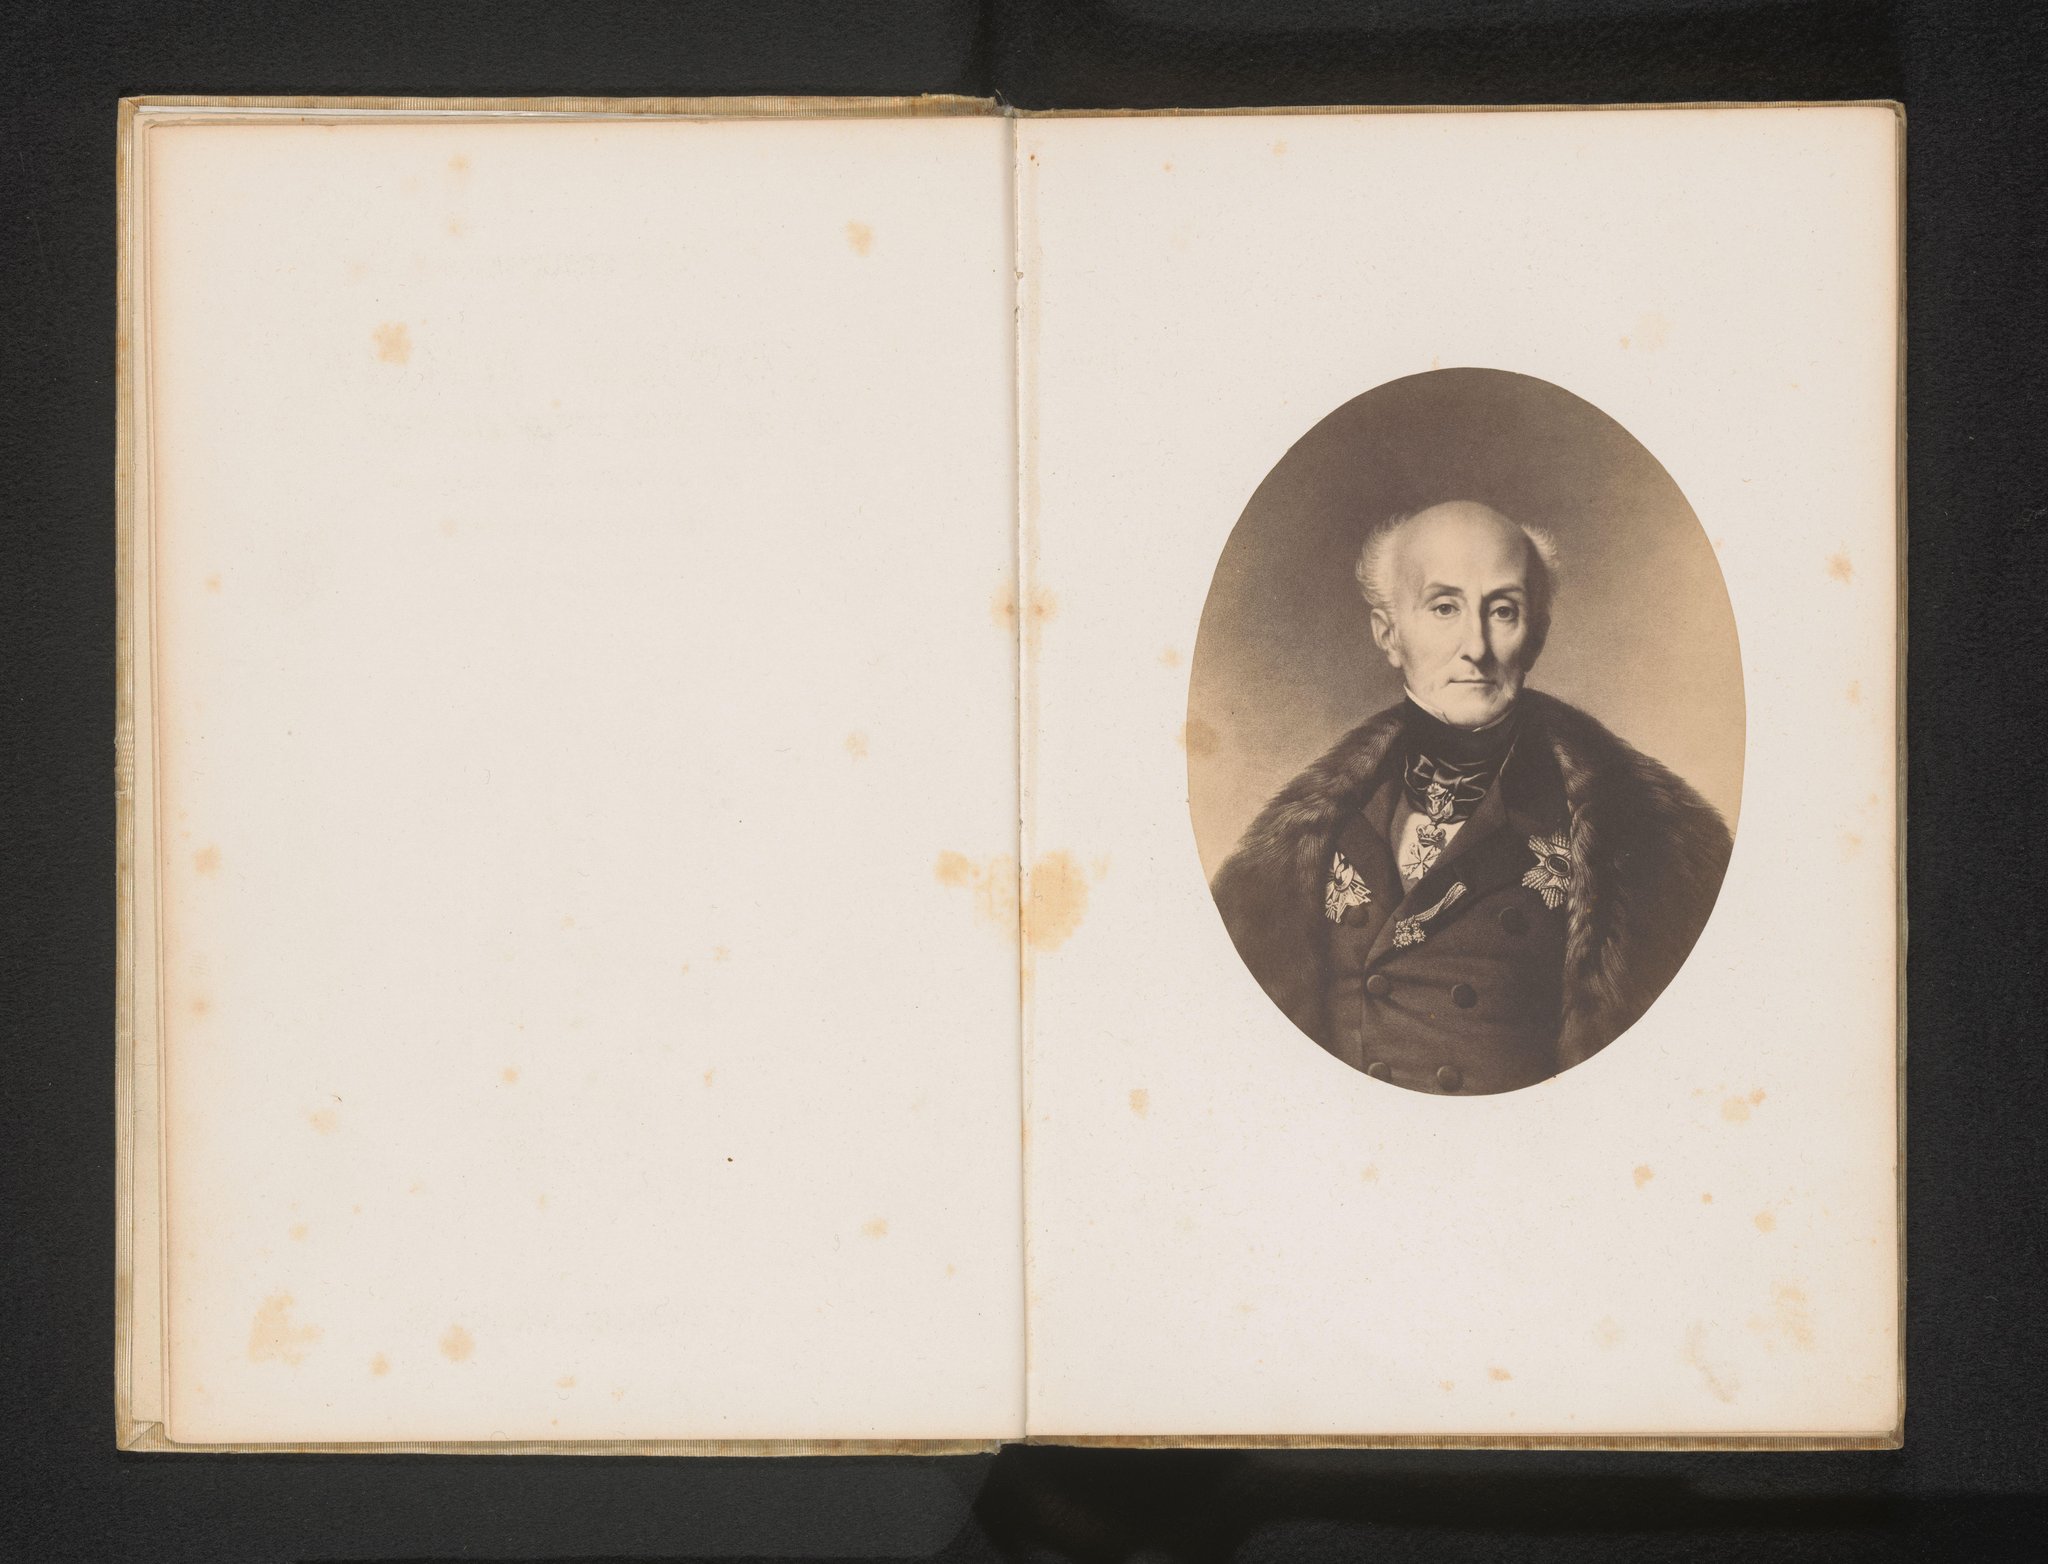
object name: page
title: Portret van een onbekende man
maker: Anonymous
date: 1849-1854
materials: photographic support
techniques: salted paper print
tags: adult man, historical persons